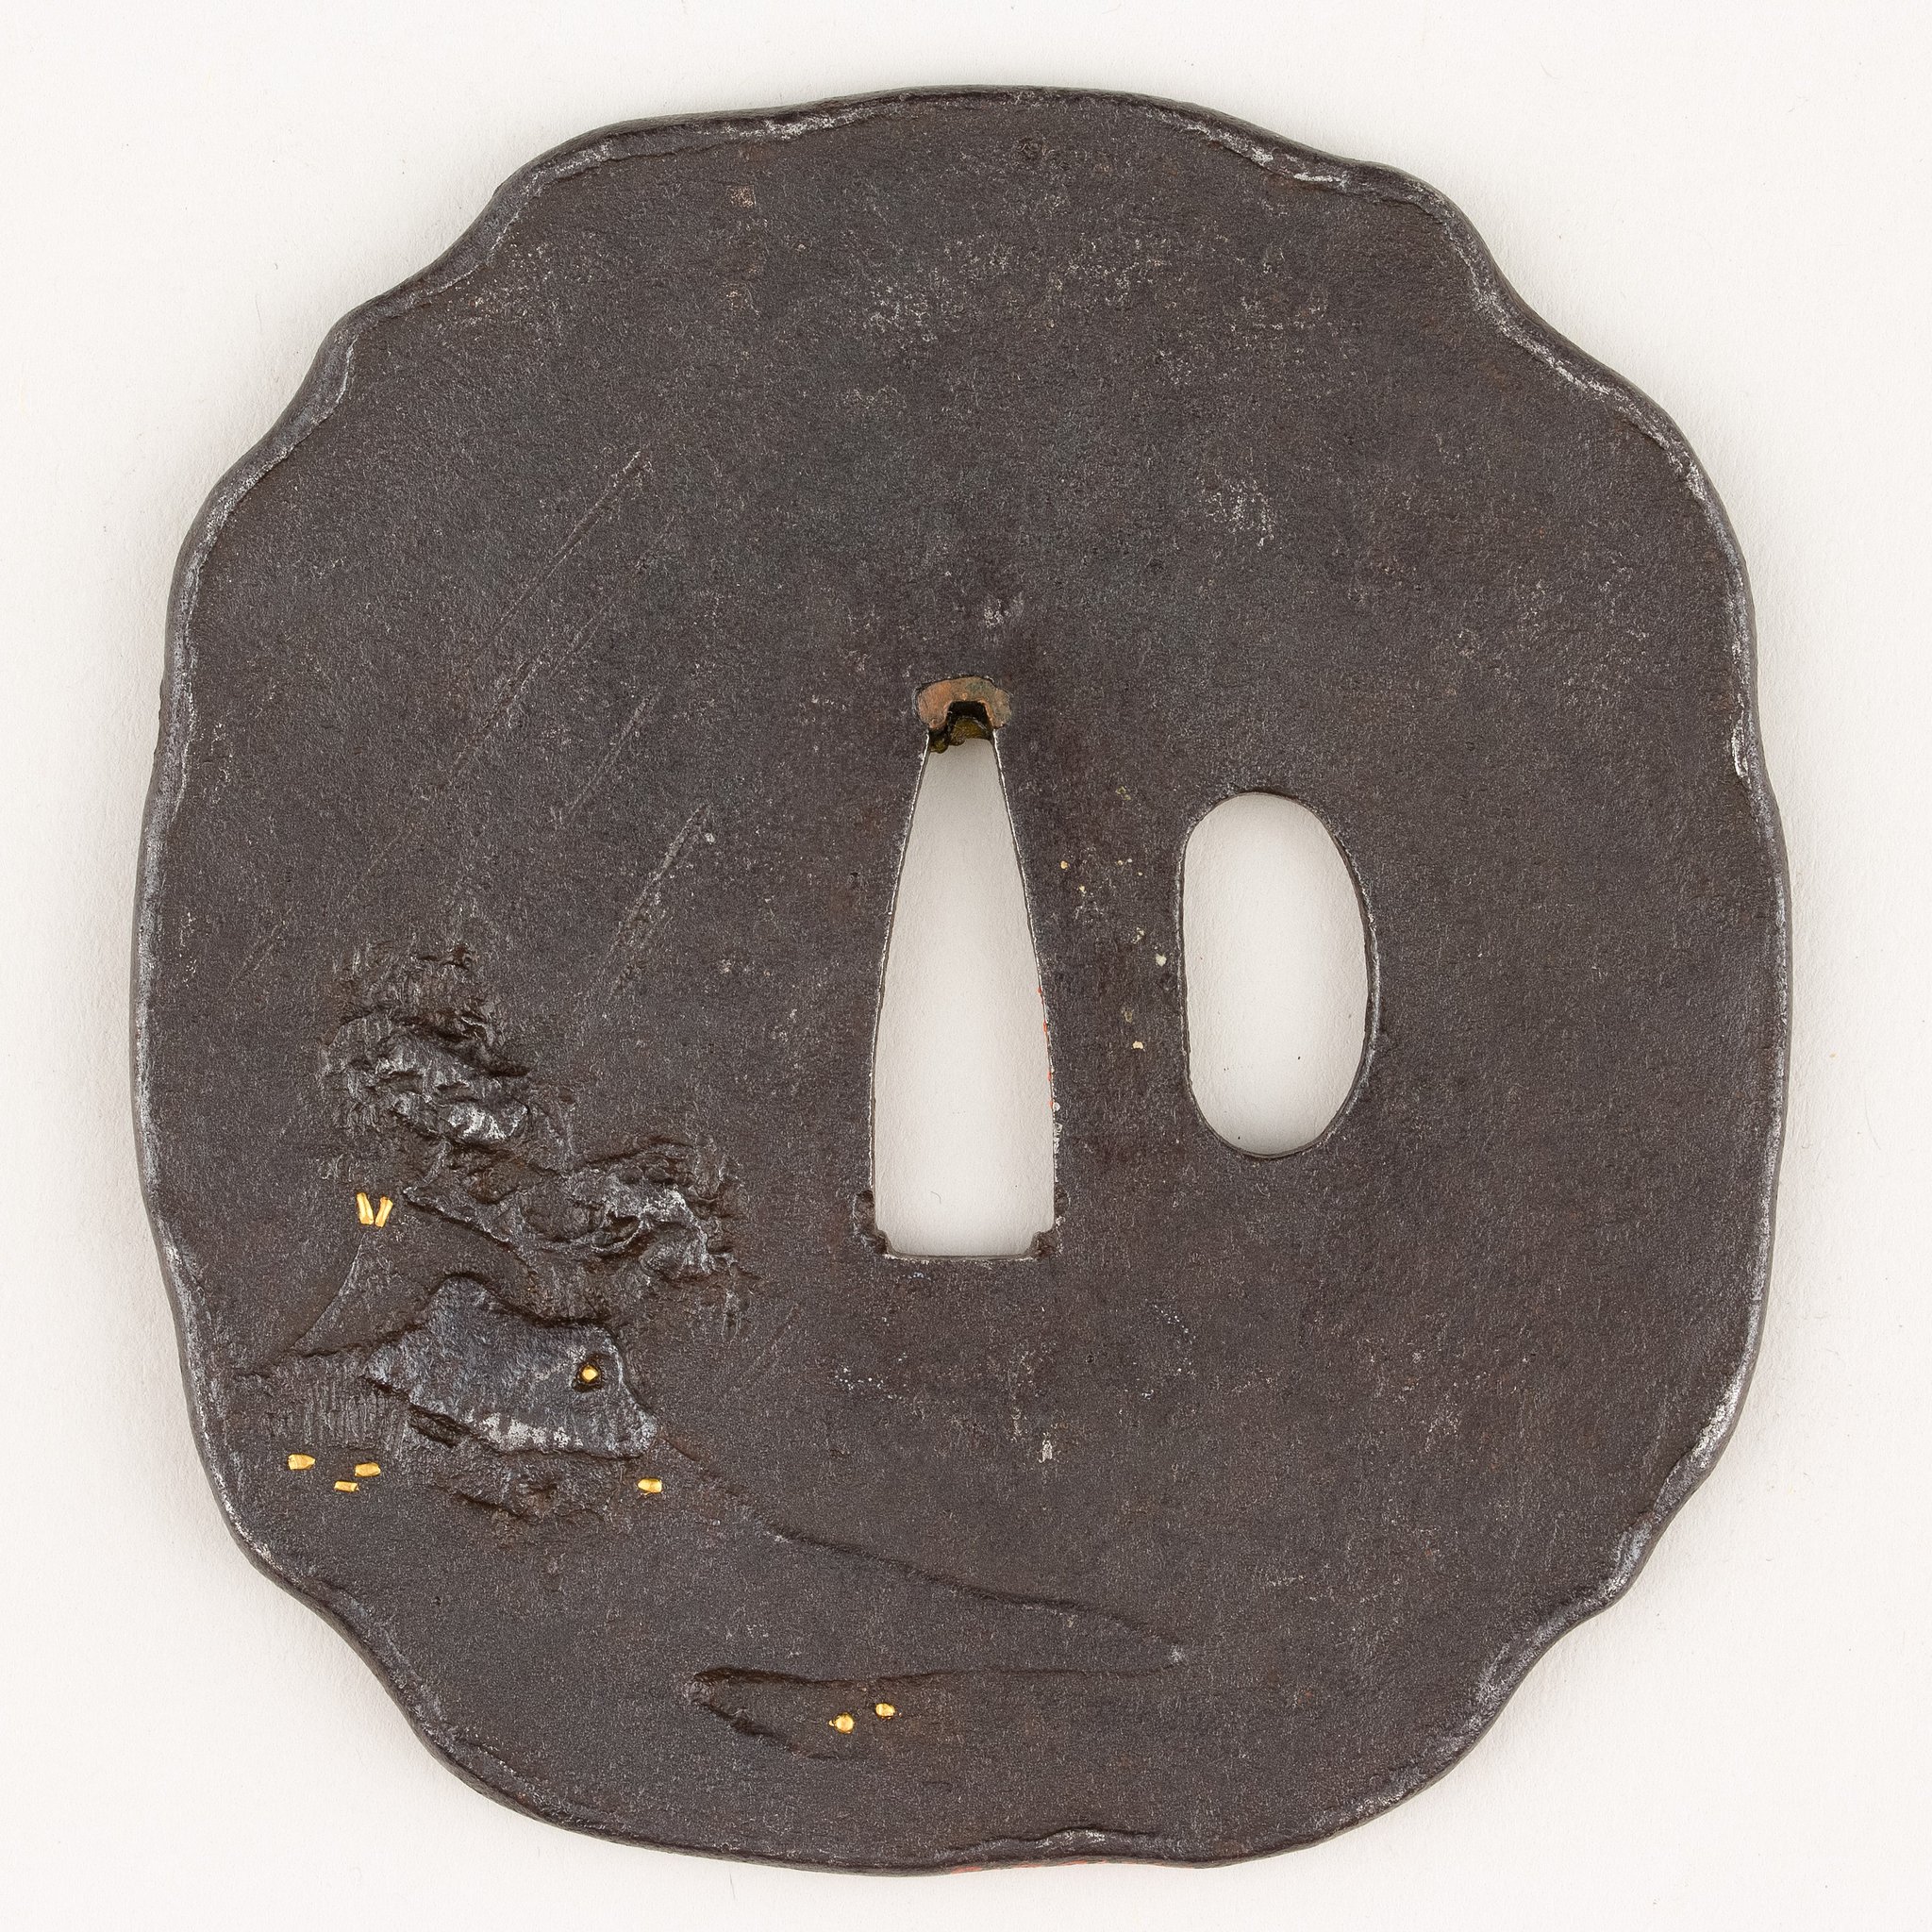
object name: sword guard tsuba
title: Sword Guard (Tsuba)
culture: japanese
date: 1600-1625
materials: gold, iron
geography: japan